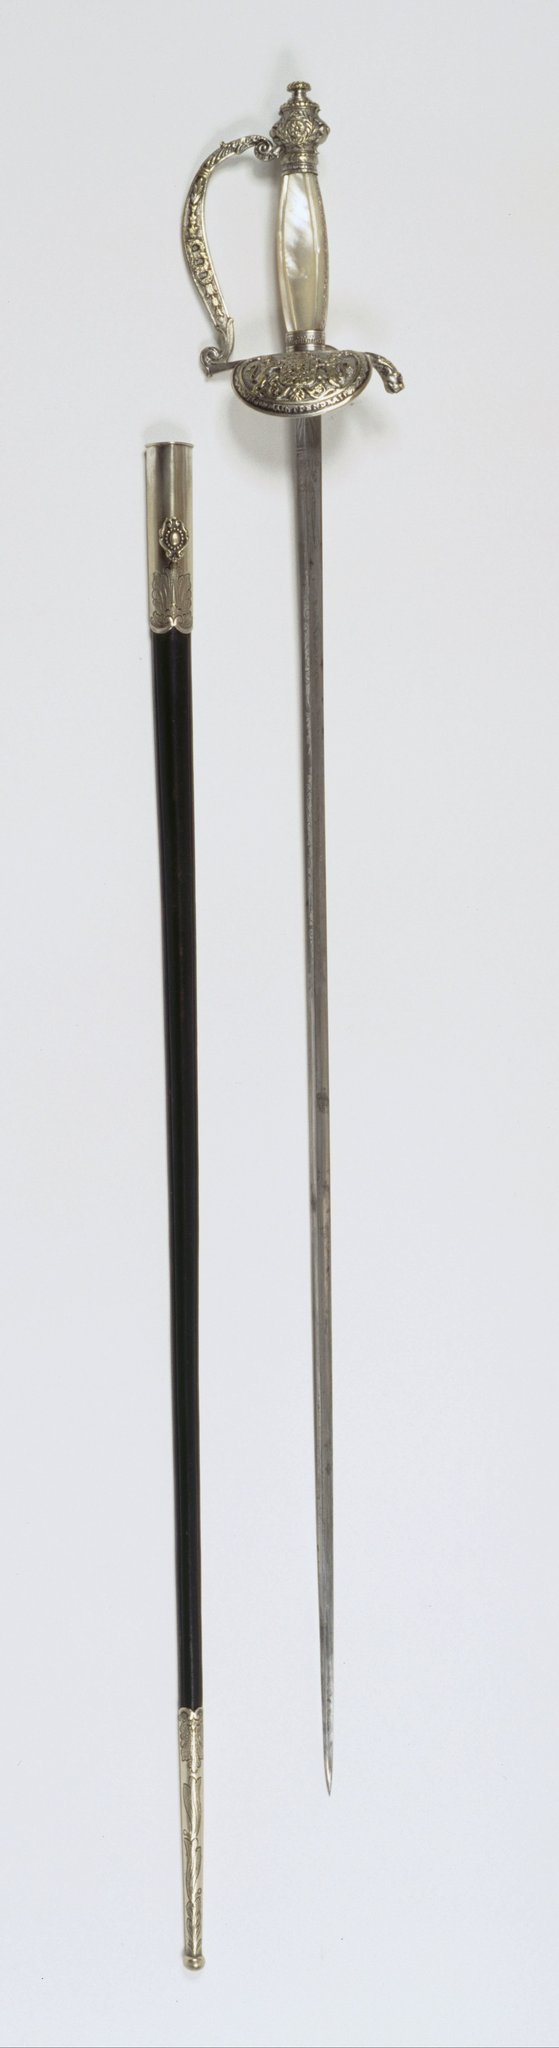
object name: dress sword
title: Degen van Mr Ch. J. M.A. van Rooy, gouverneur van Limburg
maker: Anonymous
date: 1921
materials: felt, leather, metal, mother of pearl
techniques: engraving, gilding, relief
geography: netherlands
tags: rotterdam, mayor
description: Degen met schede met op greepkap 'Je Maintendrai', goudkleurig gevest. Behorende bij het ambtskostuum van C.J.M.A. van Rooy, gouverneur van Limburg.